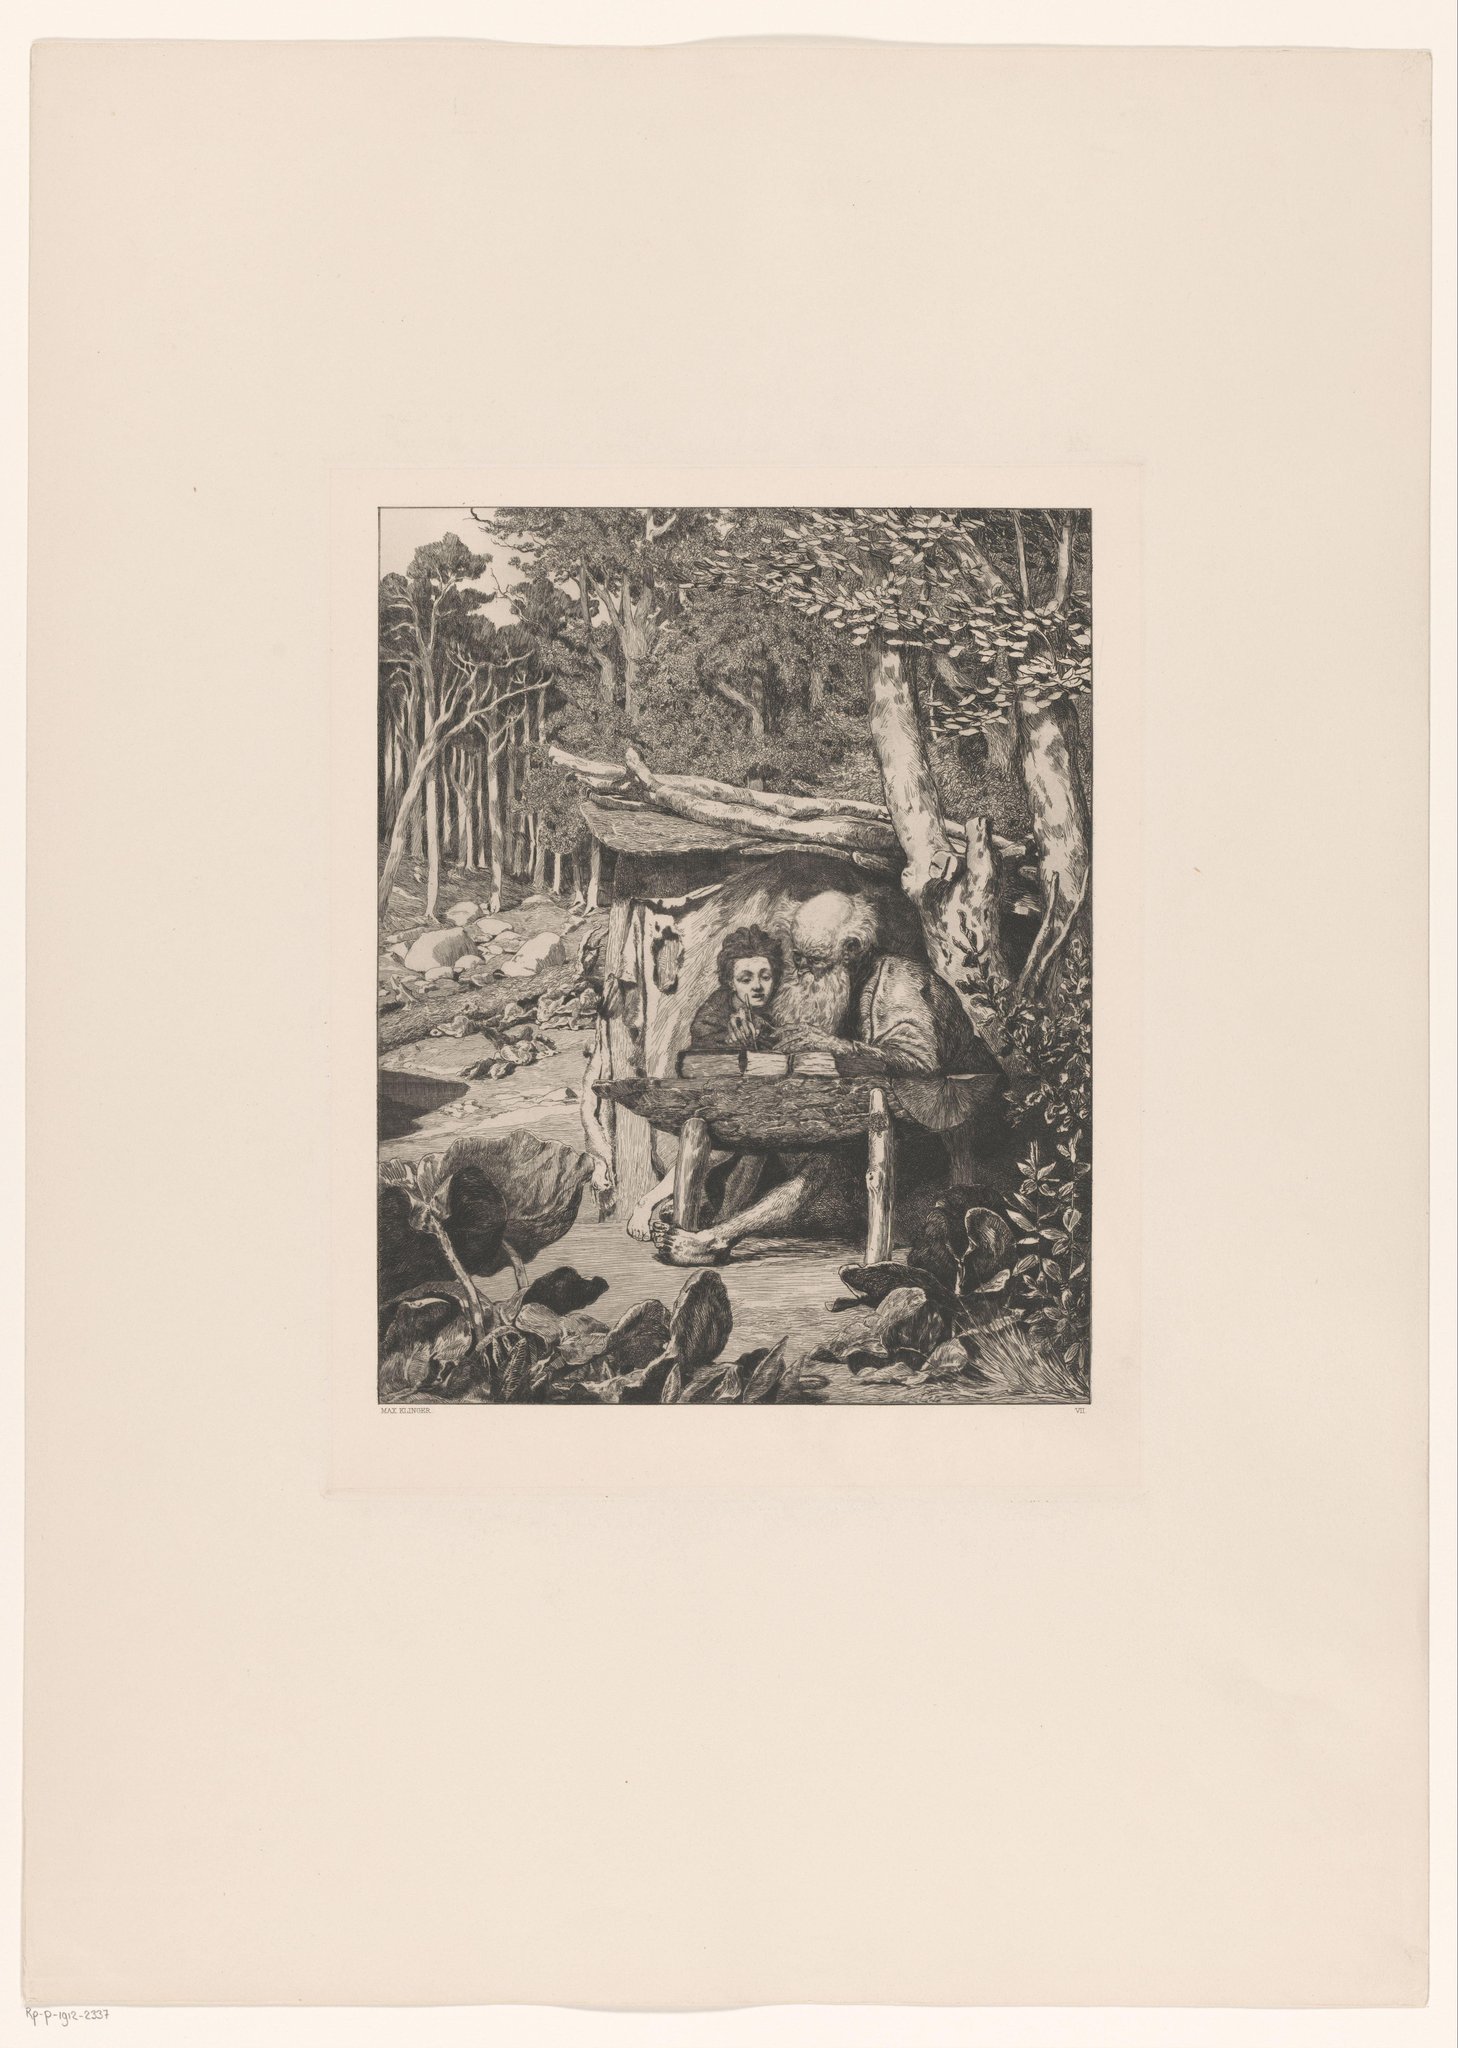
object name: print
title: Intermezzi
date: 1881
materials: paper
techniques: drypoint, etching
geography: munich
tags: handwriting, writing as activity, anchorite, hermit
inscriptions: collector's mark: Lugt 2228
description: Prent zeven uit een serie van twaalf prenten.